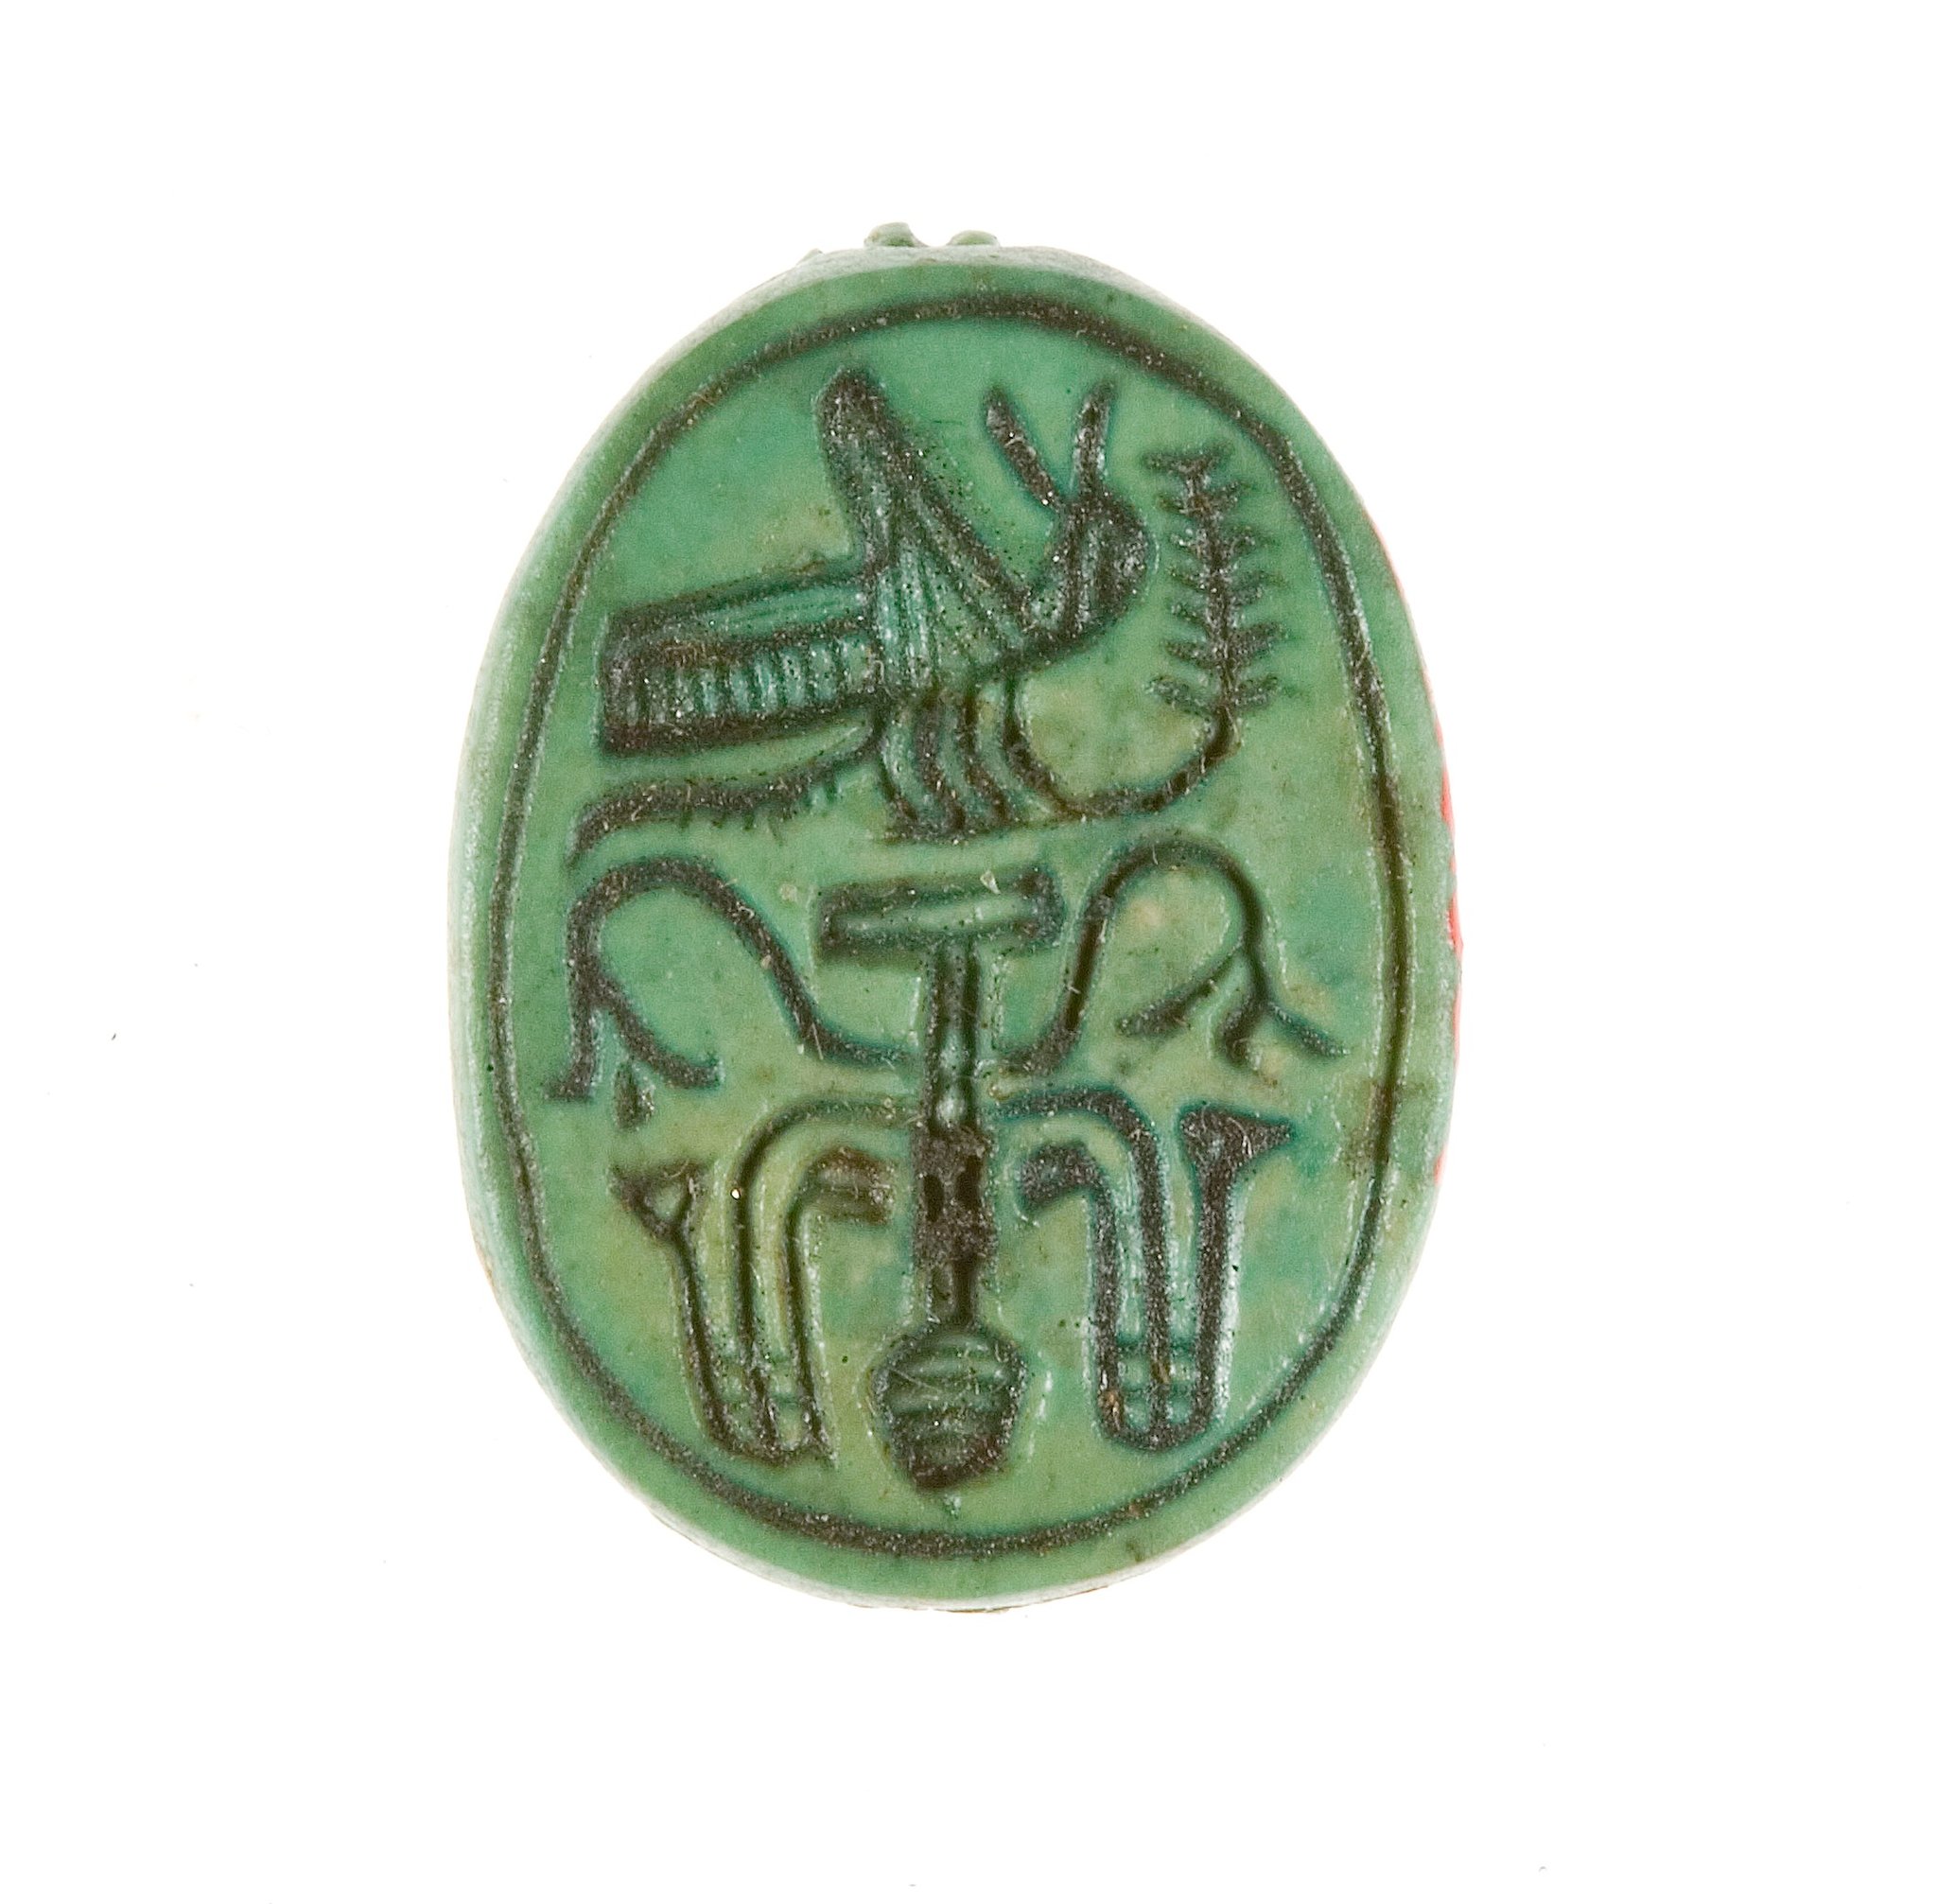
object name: scarab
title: Scarab Inscribed with a Hieroglyphic Motif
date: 1479-1458 BCE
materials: stone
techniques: glazing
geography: egypt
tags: hieroglyphs,scarabs